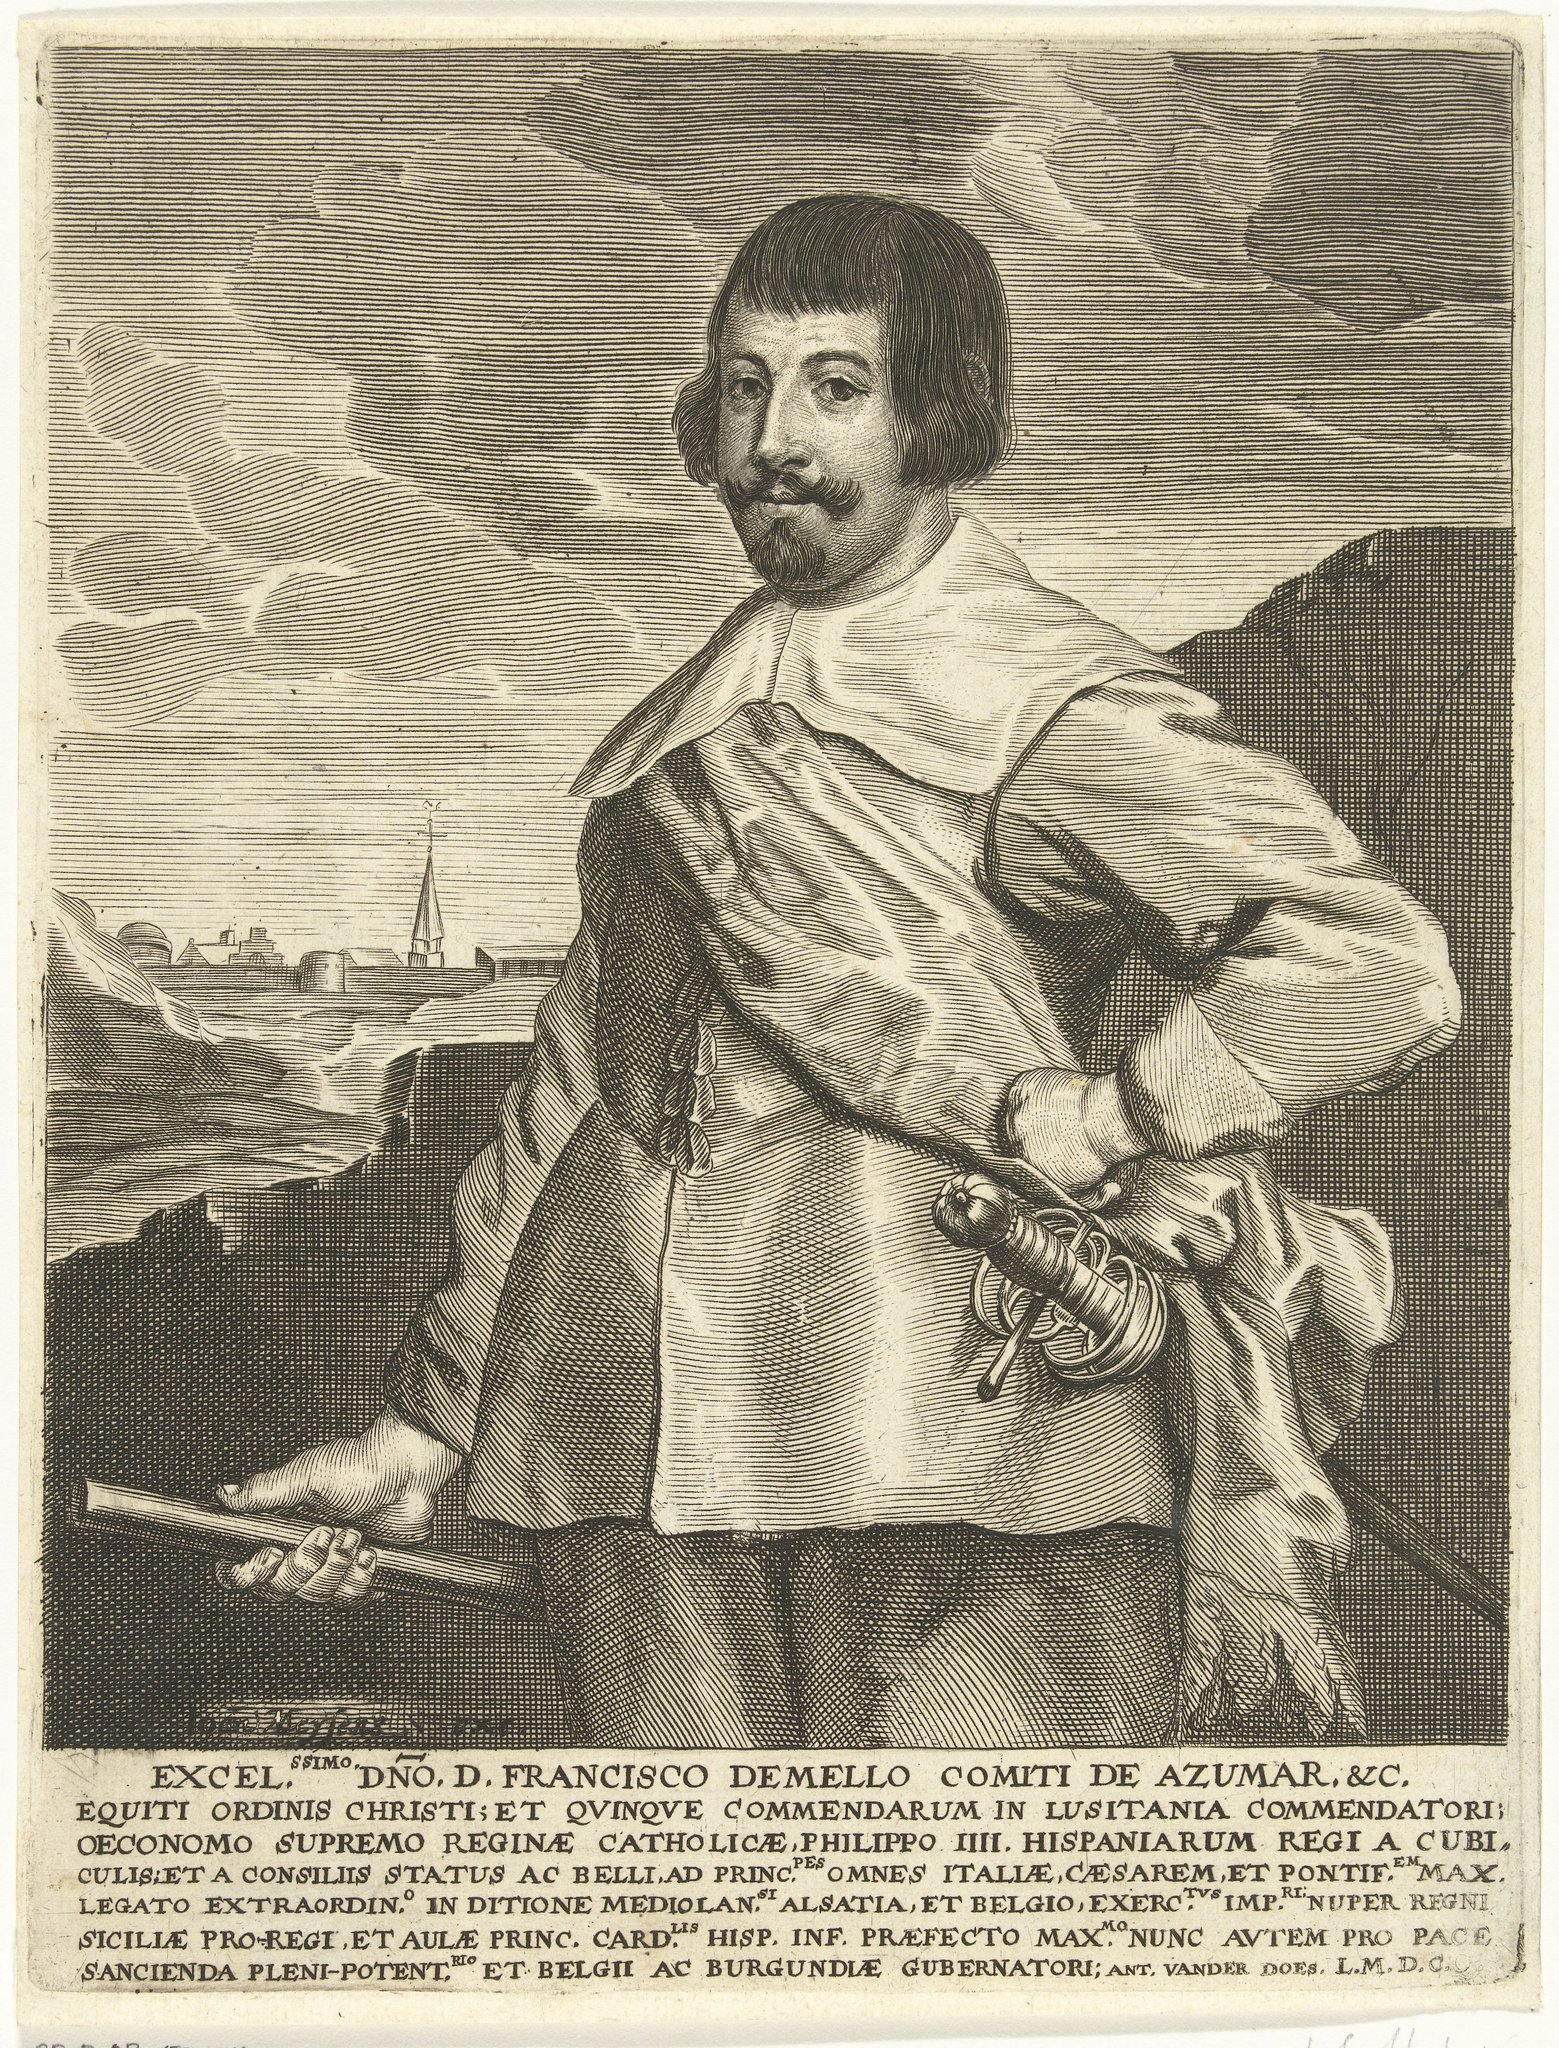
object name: print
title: Portret van Francisco de Melo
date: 1619-1680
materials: paper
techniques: engraving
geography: southern netherlands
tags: governor, etc. of province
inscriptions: collector's mark: Lugt 2228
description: Portret van Francisco de Melo, kniestuk, staand voor landschap met ommuurde stad. In ondermarge zeven regels Latijnse tekst.